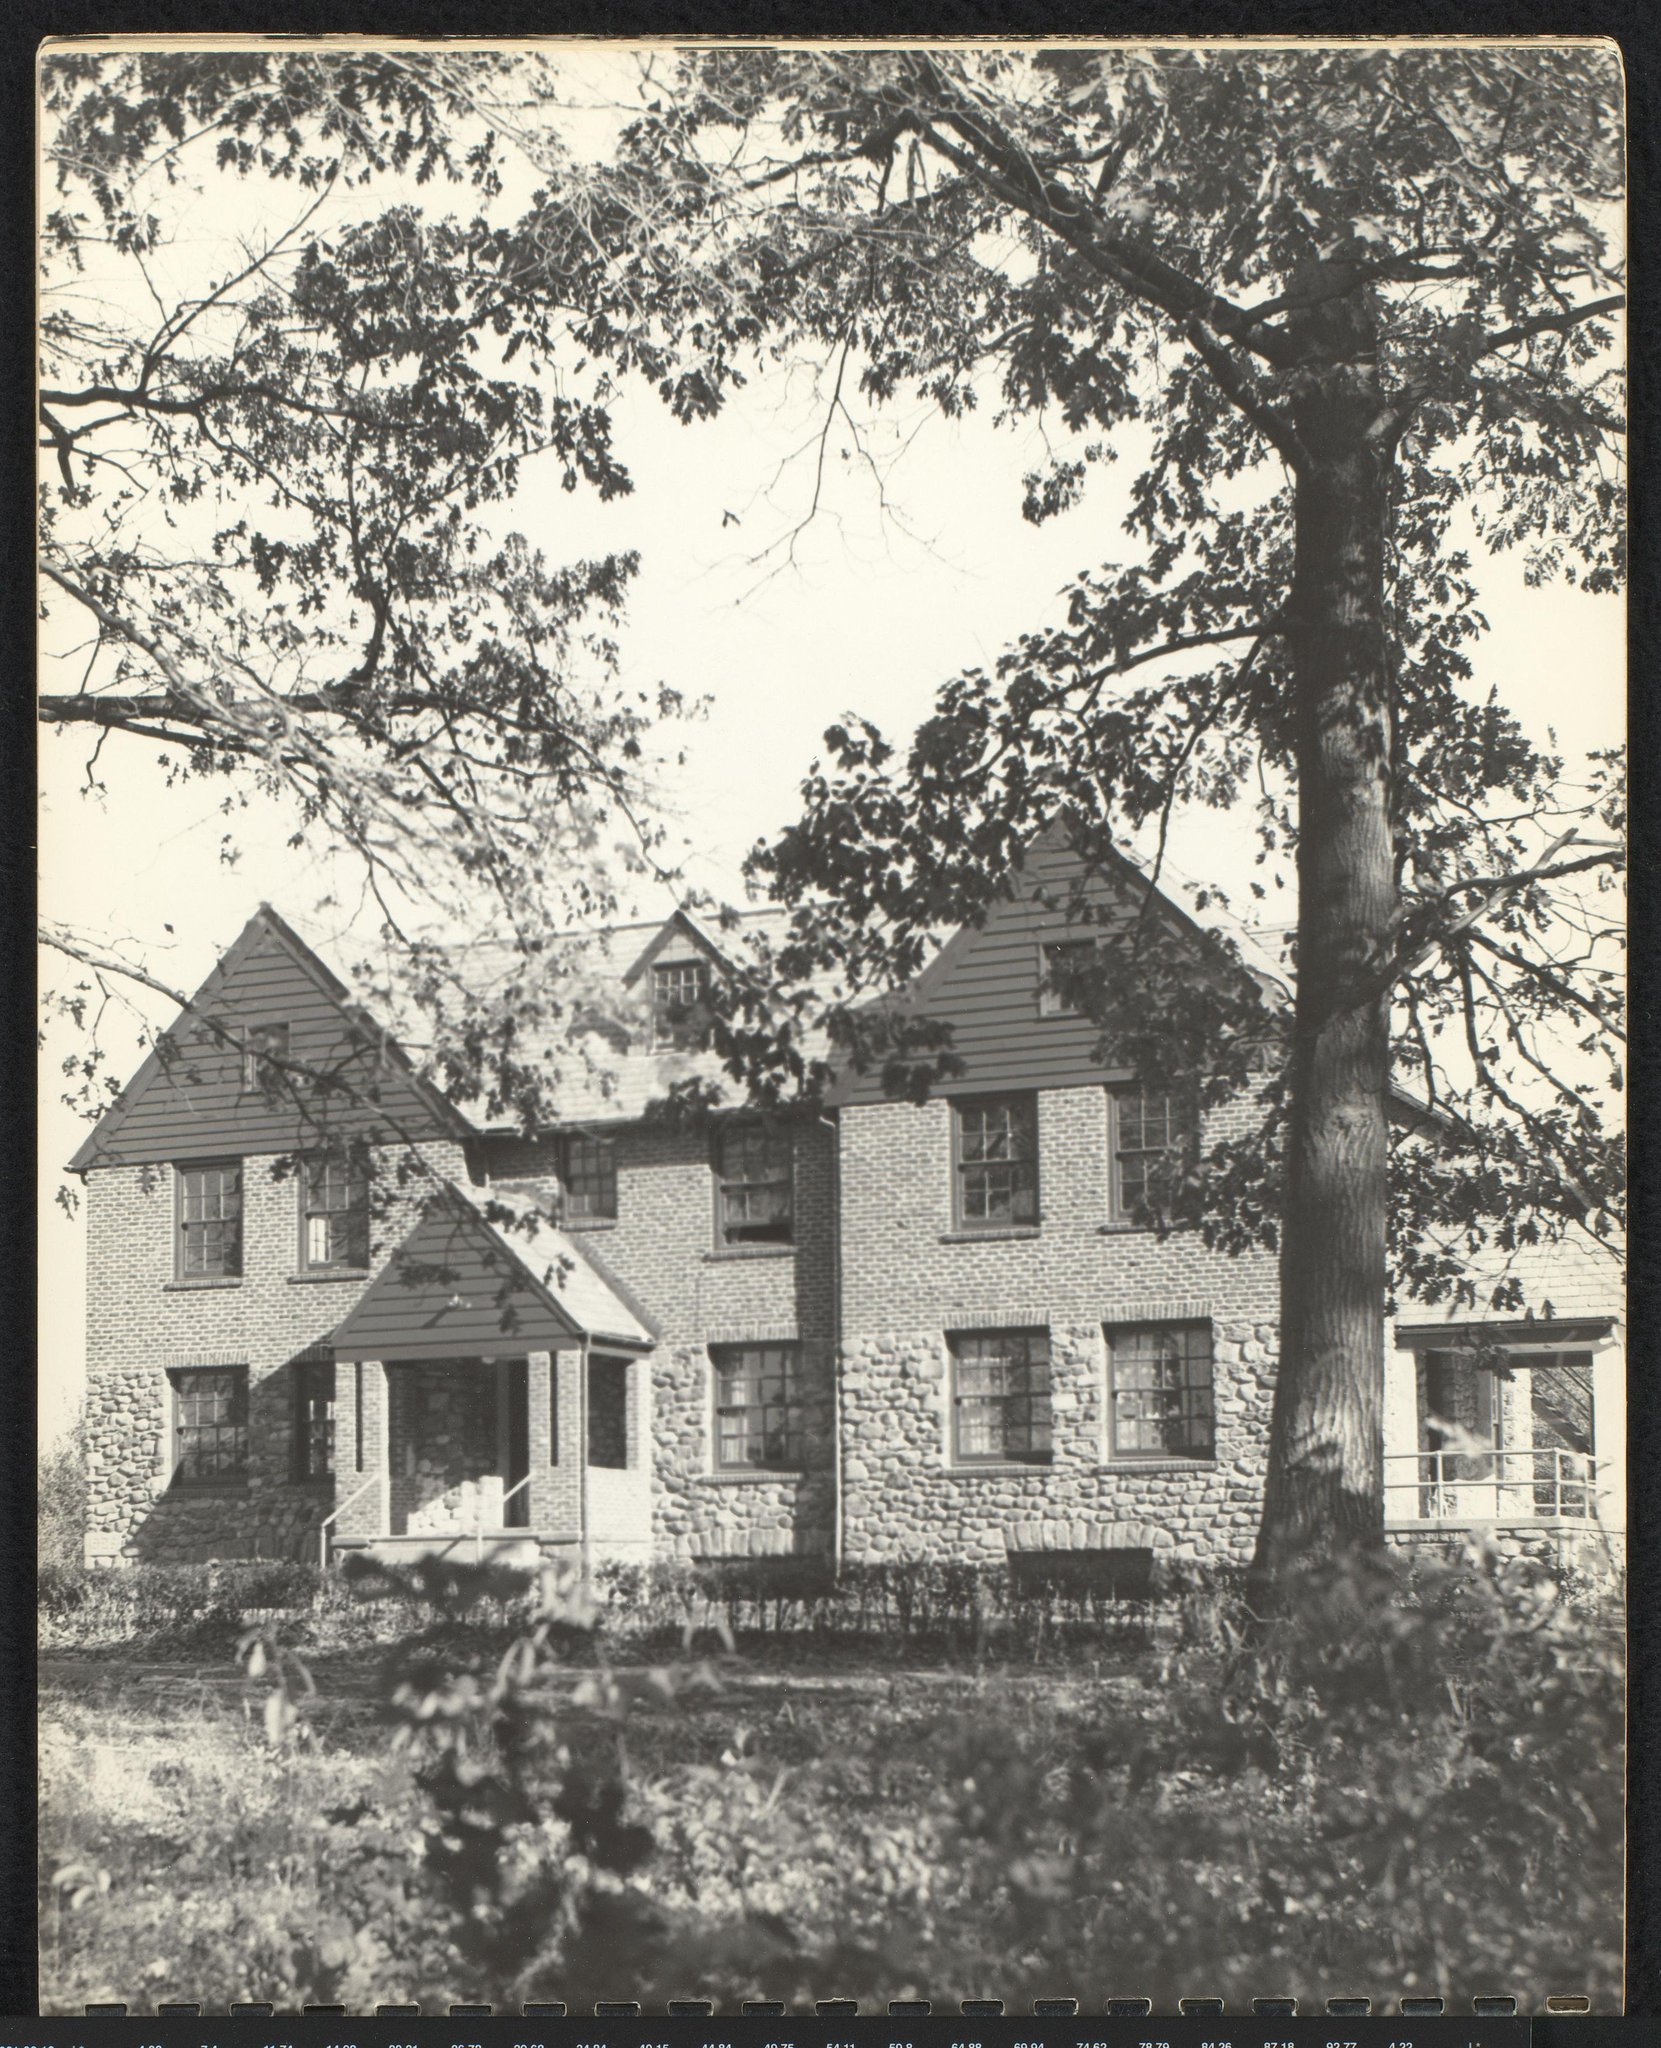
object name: photograph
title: ‘Enos’ Cottage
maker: Anonymous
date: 1950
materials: paper, photographic support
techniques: gelatin silver print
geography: new york city